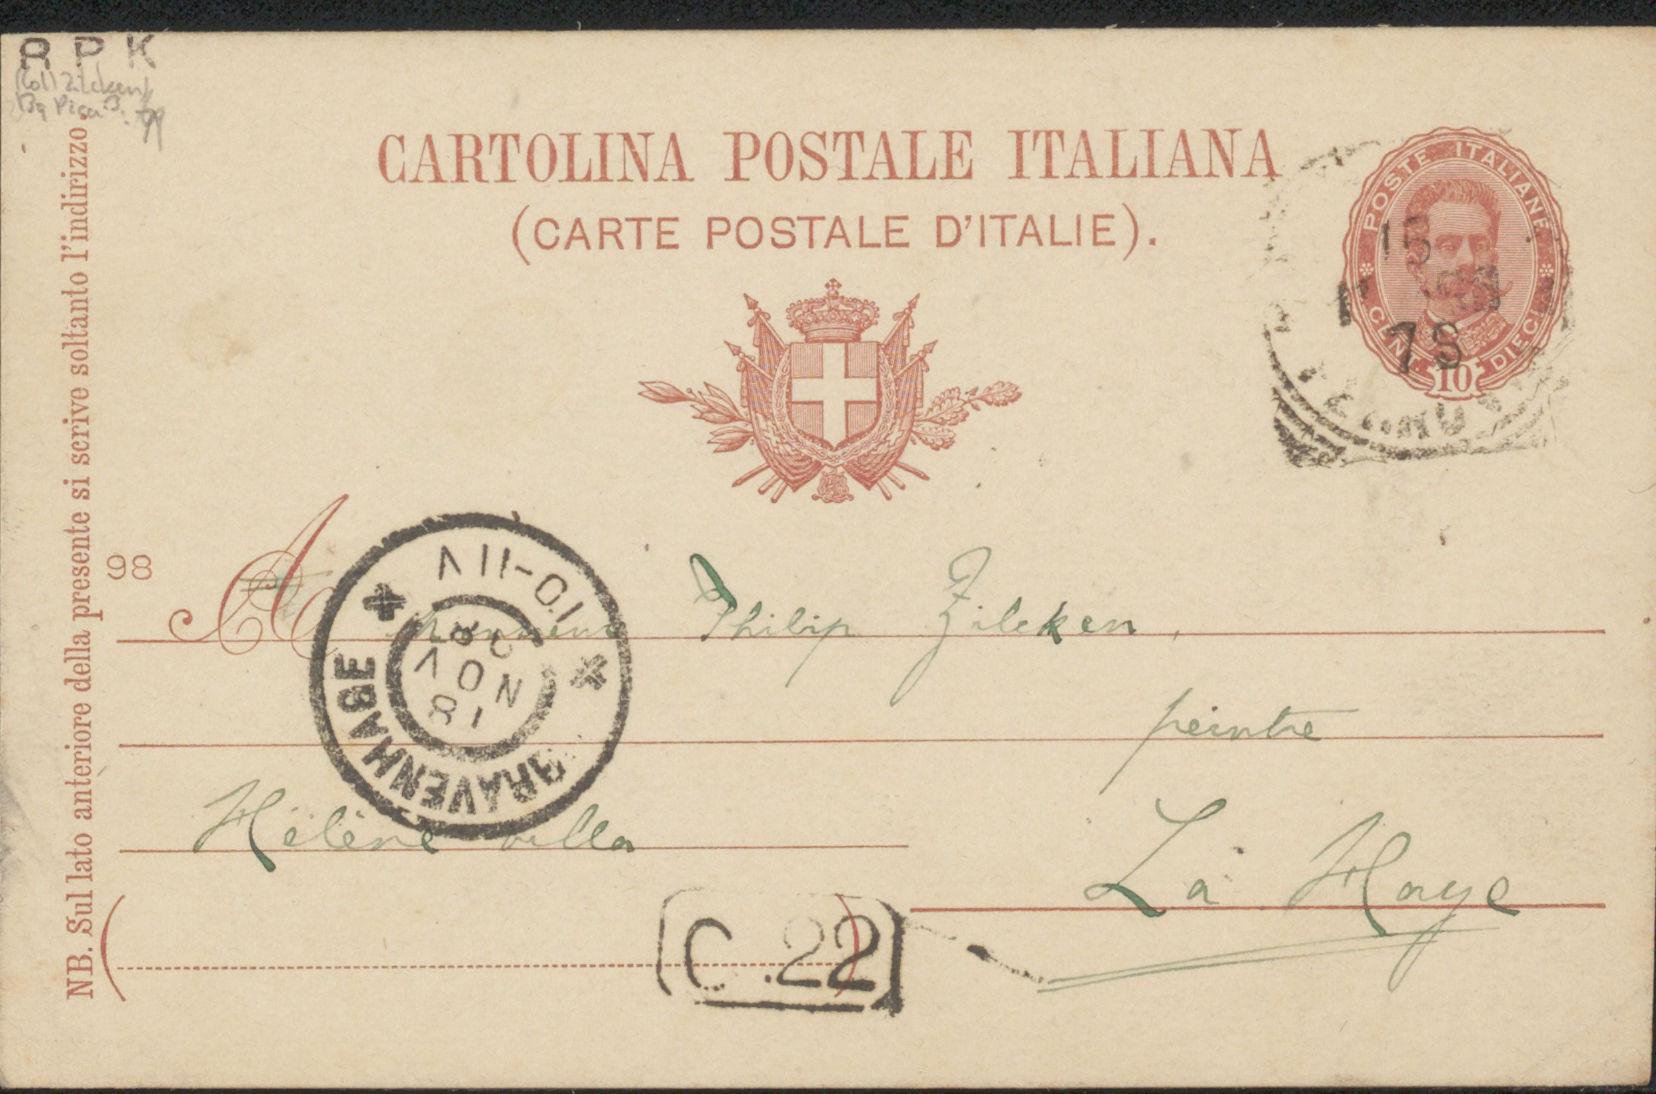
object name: postcard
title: Briefkaart aan Philip Zilcken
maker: vittorio pica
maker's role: criticus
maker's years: 1864-1930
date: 1898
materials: cardboard, ink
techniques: pen, writing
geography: naples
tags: the hague, painter, draughtsman, philip zilcken, the graphic arts, printed matter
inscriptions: collector's mark: ‘RPK’